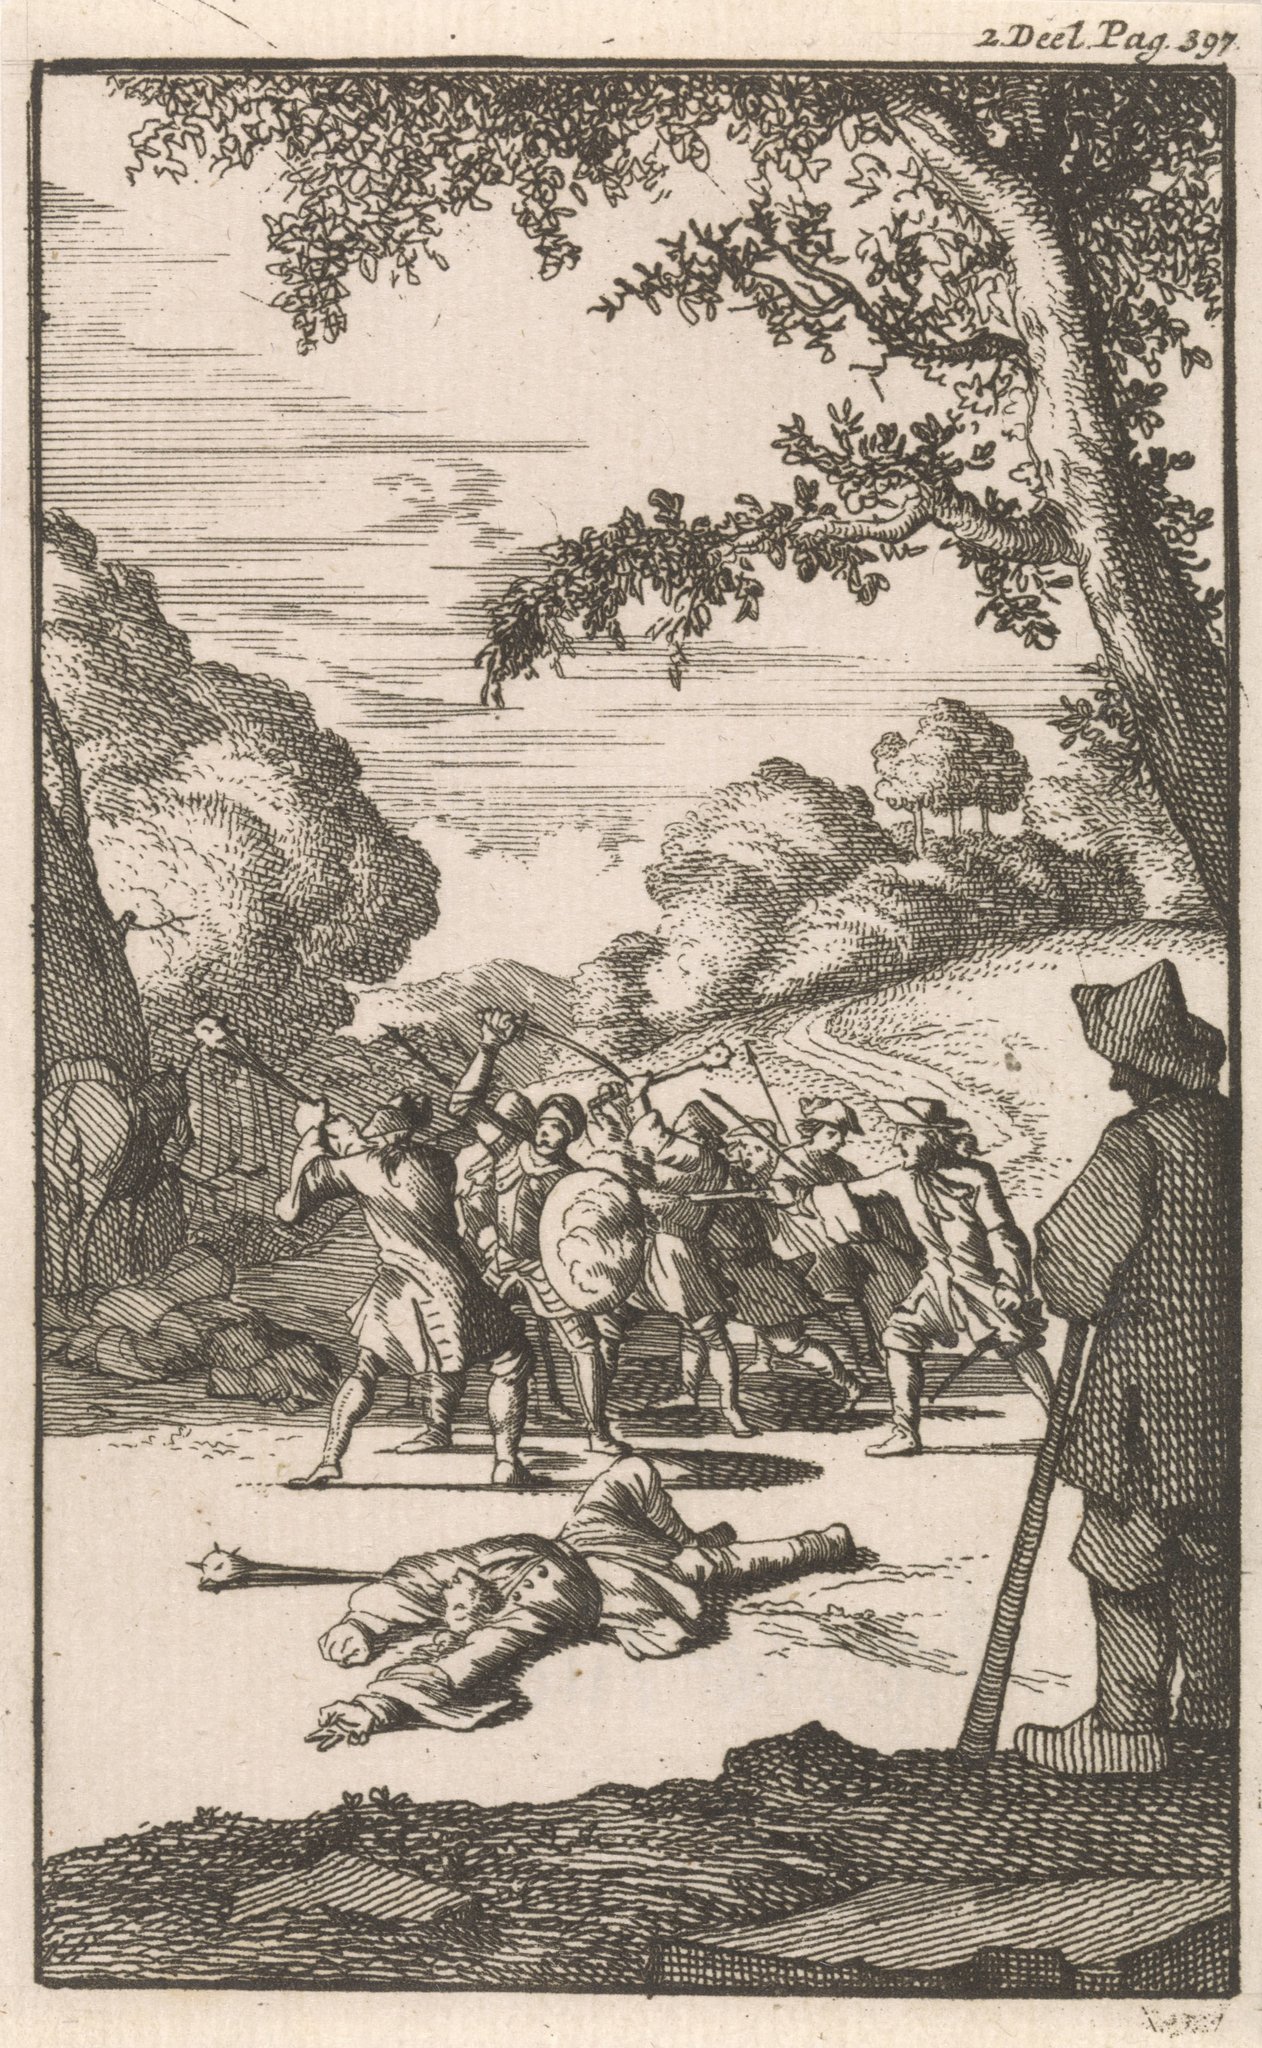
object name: book illustration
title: Strijd van Don Clarazel met de schout en zijn dienaars nabij Tours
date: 1697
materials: paper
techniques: etching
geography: amsterdam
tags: battle, knight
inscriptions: collector's mark: Lugt 2228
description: Illustratie uit: Verdier, Gilbert Saulnier du (vert. Heinsius, Nicolaas junior). Don Clarazel de Gontarnos, ofte den buiten-spoorigen dolenden ridder, 2 delen. Amsterdam: Johannes Broersz en Nathanael Holbeex, 1697, dl. 2.